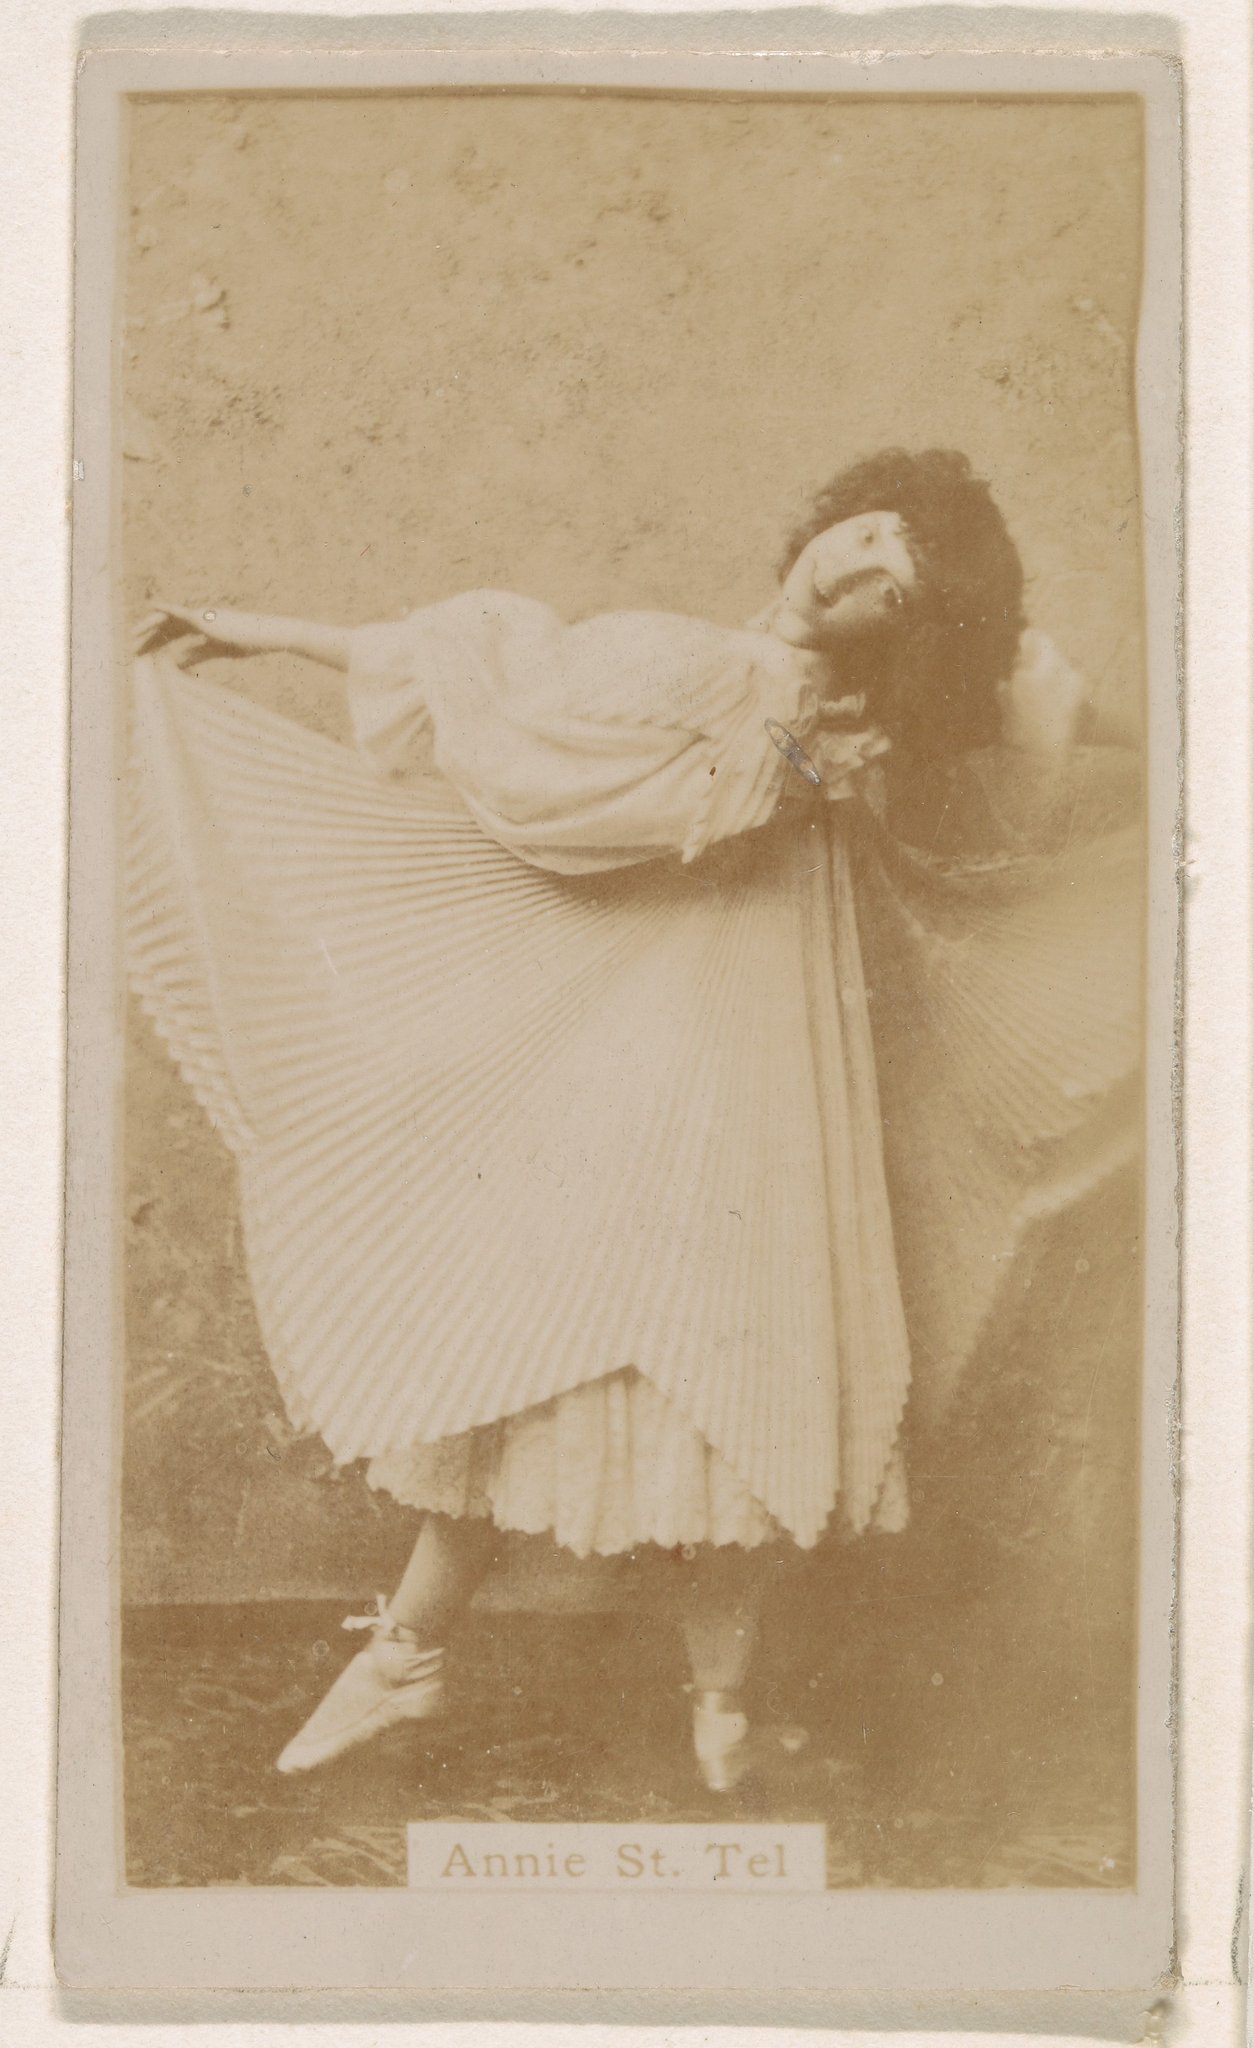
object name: photograph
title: Annie St. Tel, from the Actresses series (N245) issued by Kinney Brothers to promote Sweet Caporal Cigarettes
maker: kinney brothers tobacco company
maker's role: publisher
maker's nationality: american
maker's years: 1869-2011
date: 1890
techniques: albumen silver print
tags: portraits,women,actresses